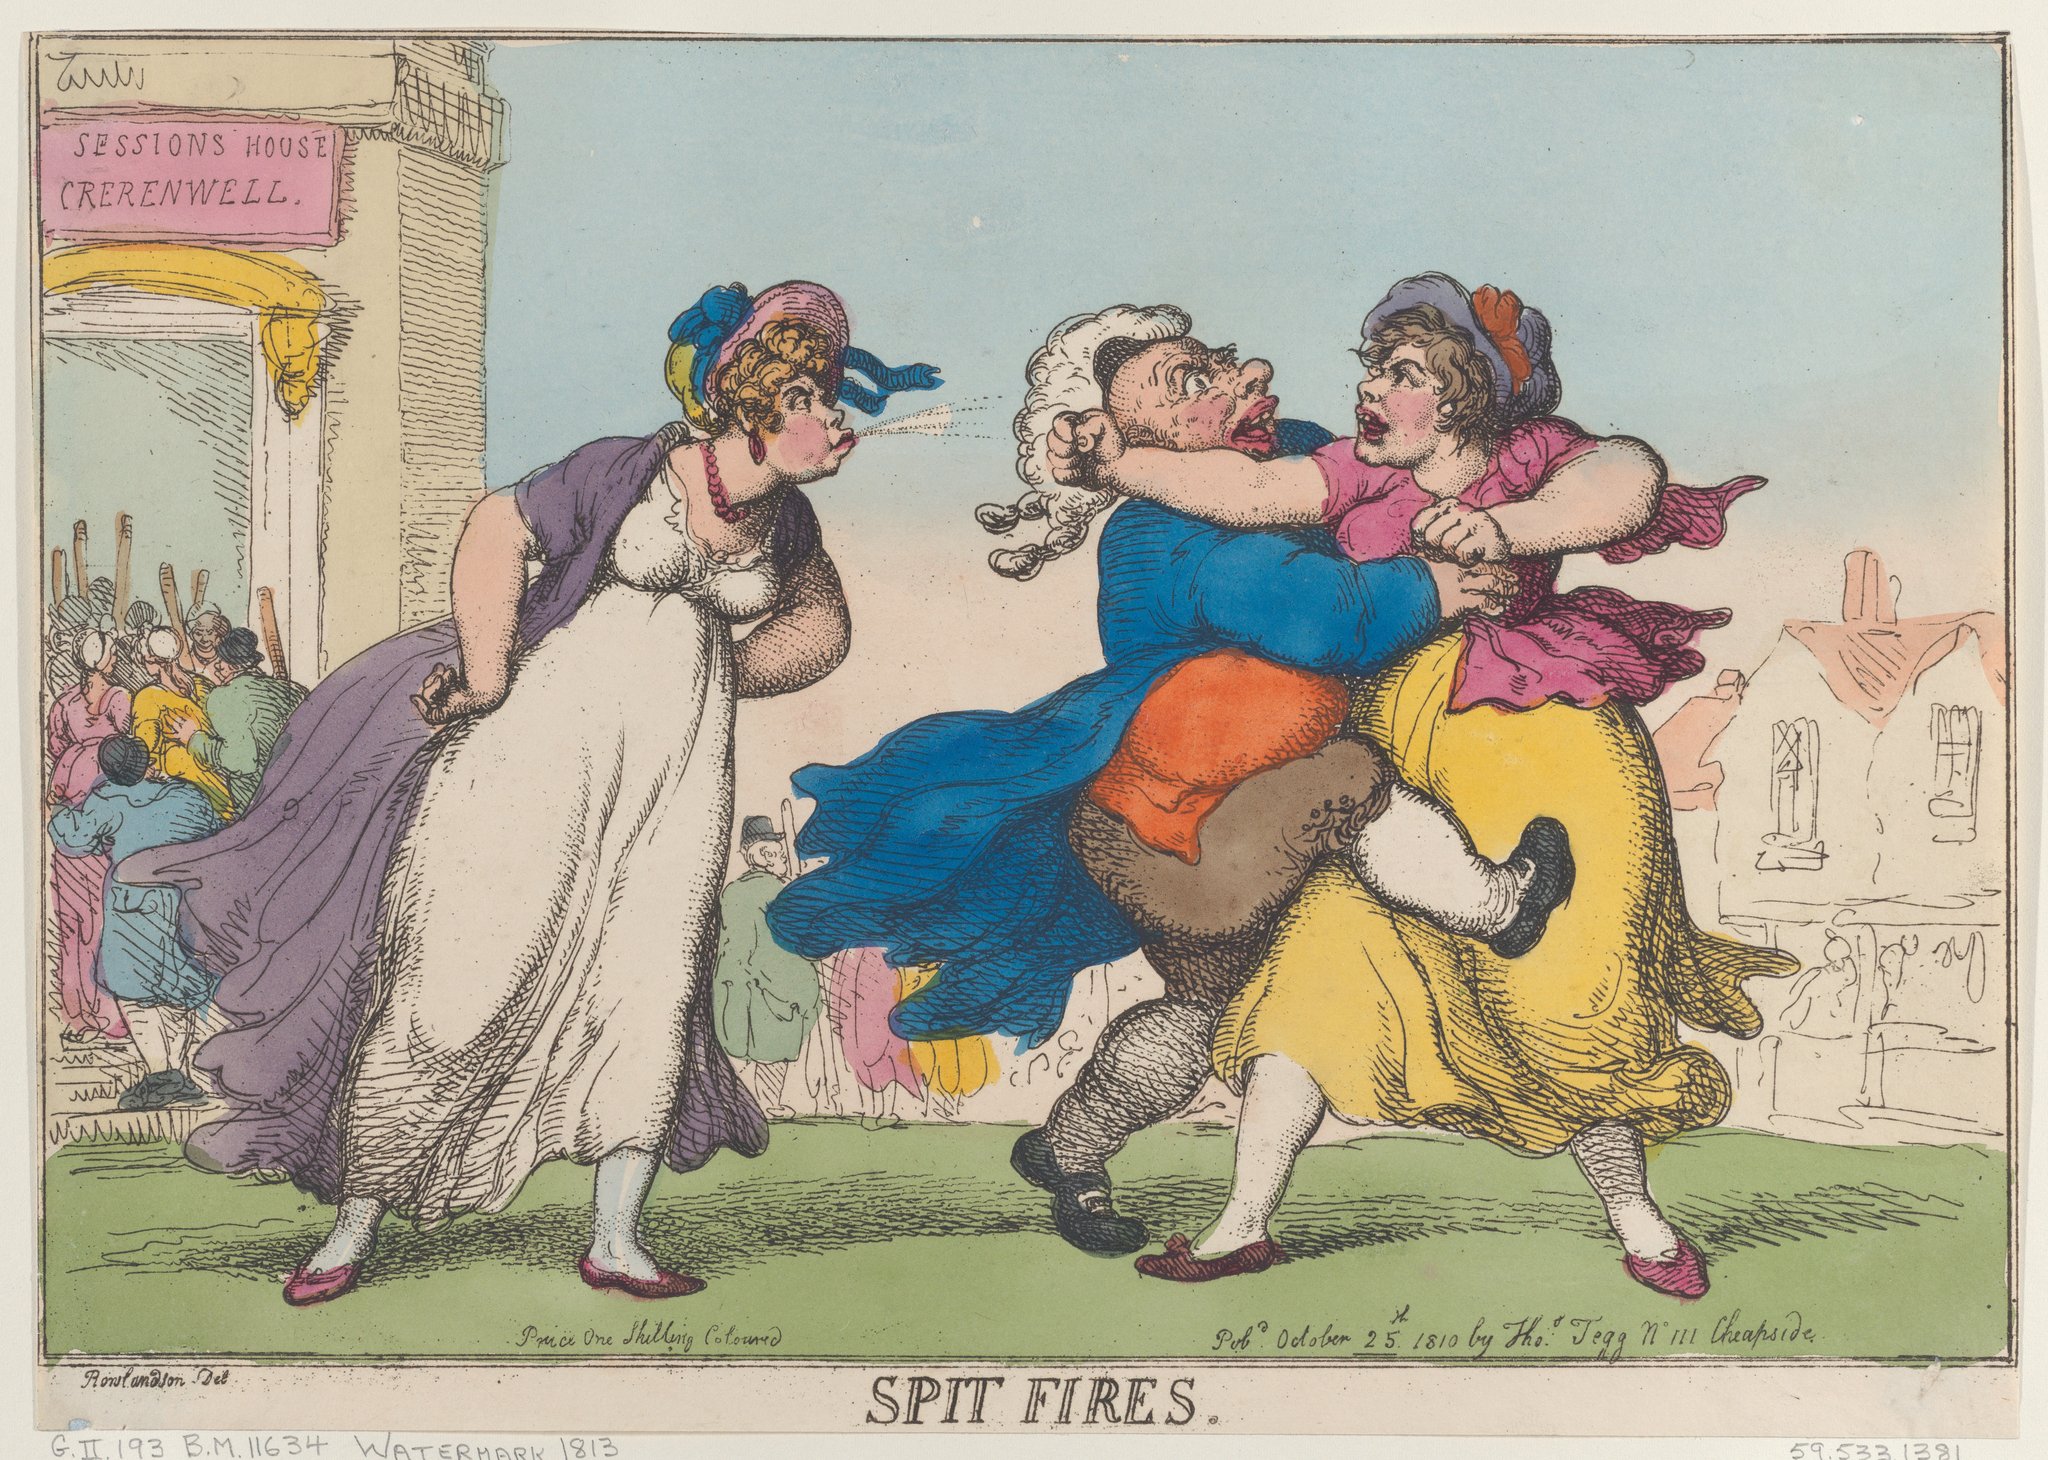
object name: print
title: Spit Fires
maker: thomas rowlandson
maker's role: artist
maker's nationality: british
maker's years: 1757-1827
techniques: etching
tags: satire,men,women